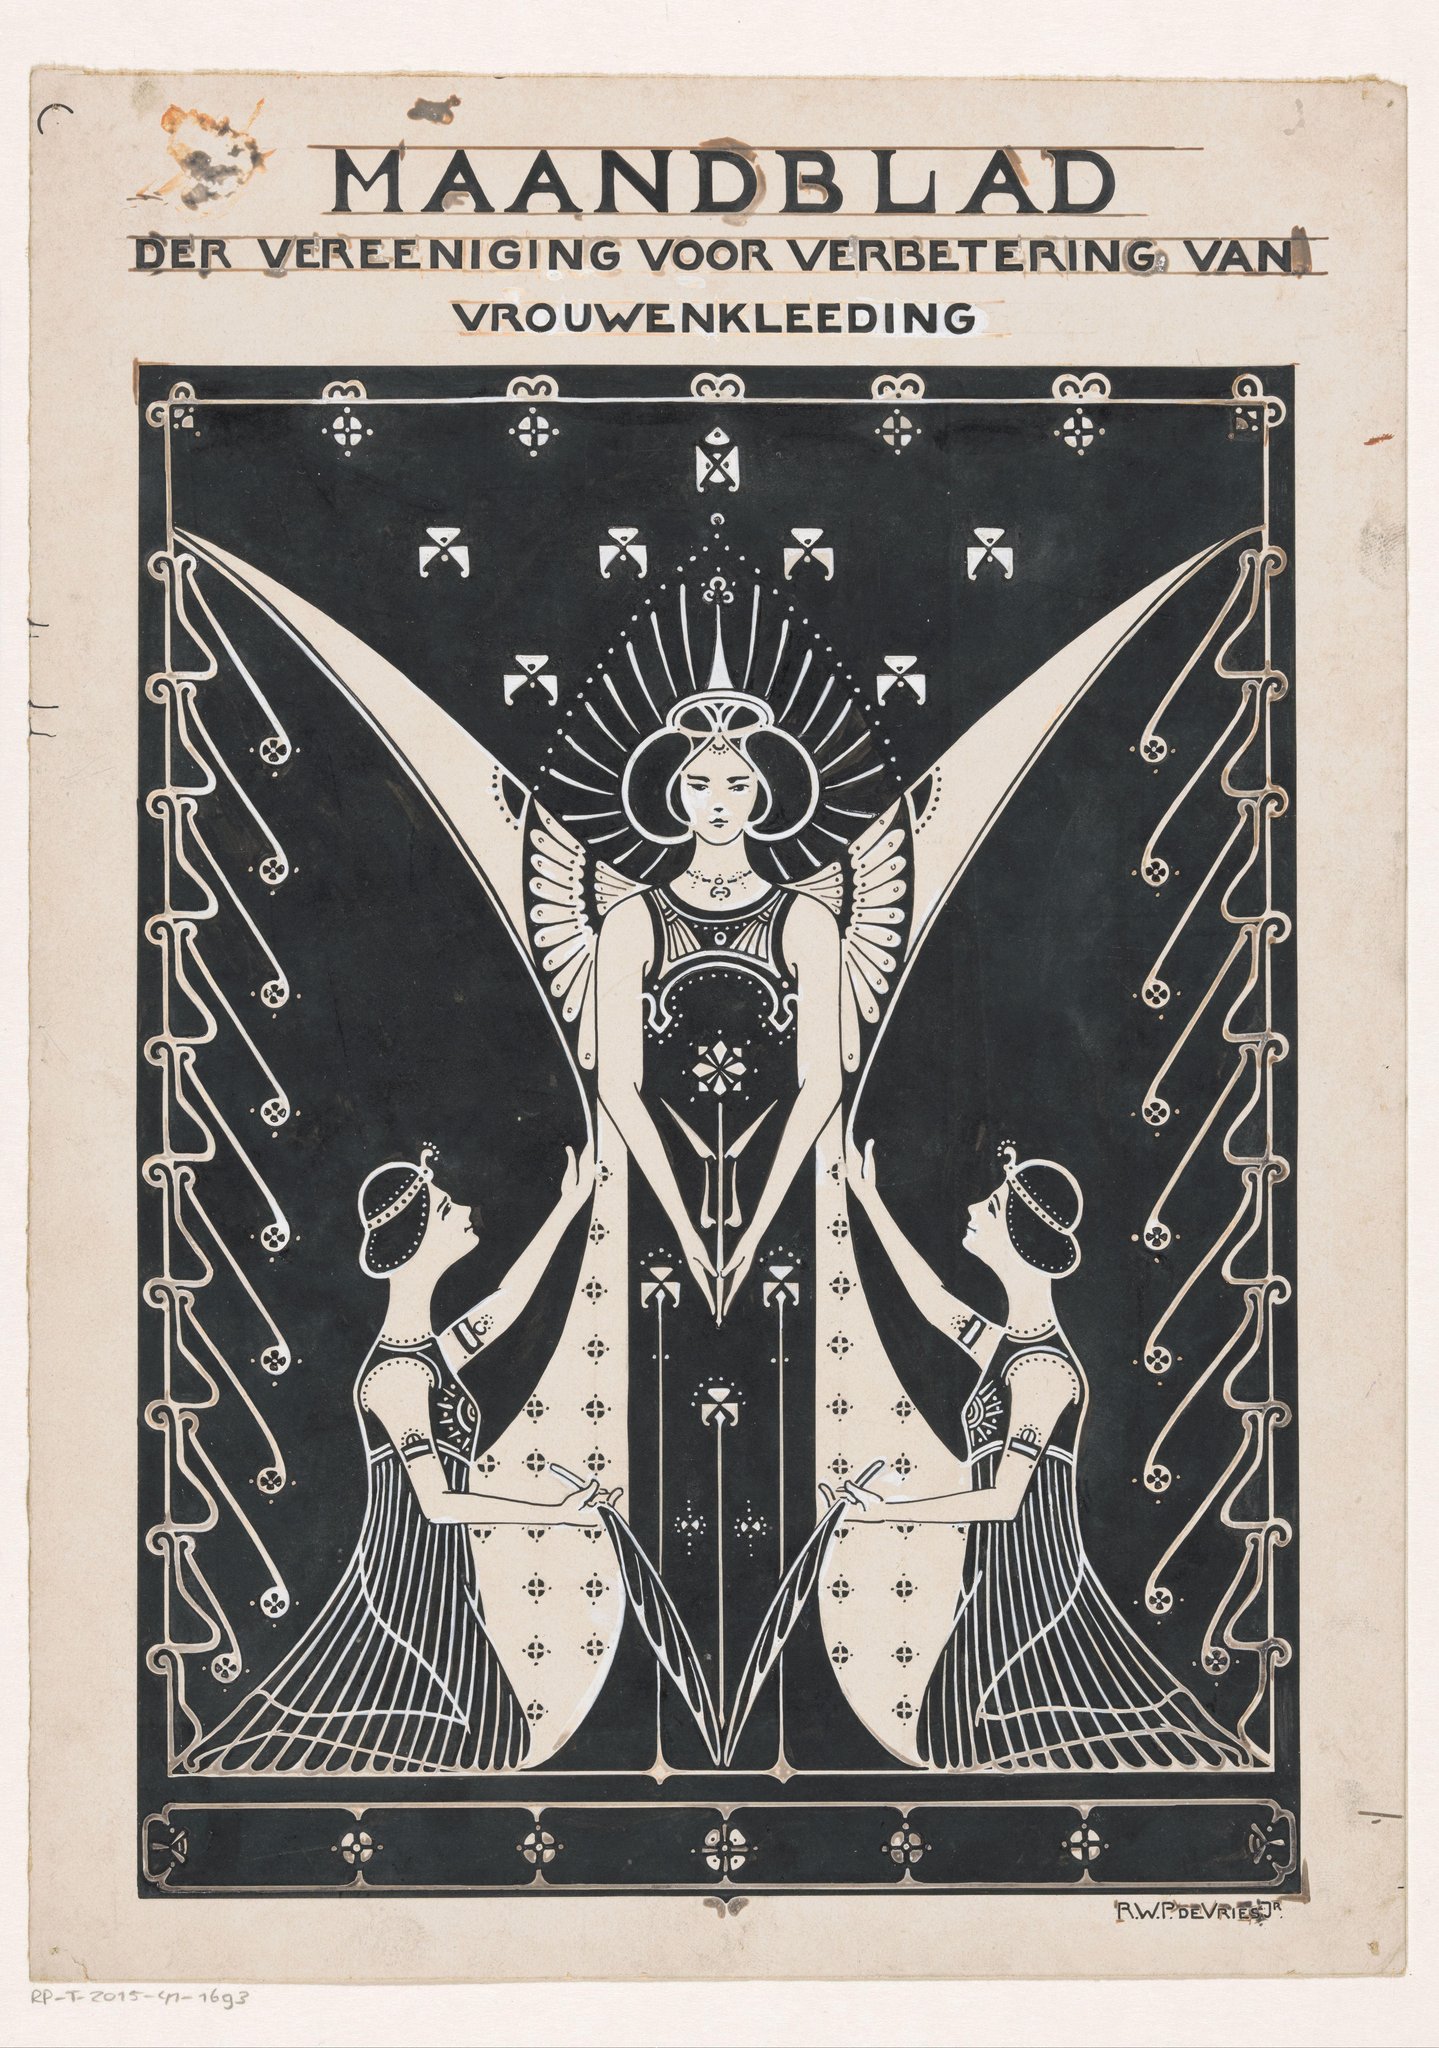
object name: drawing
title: Omslagontwerp voor: Maandblad der Vereeniging voor verbetering van vrouwenkleeding, c. 1901-1909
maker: reinier willem petrus de vries (1874-1953)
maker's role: draughtsman, print maker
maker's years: 1874-1953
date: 1901-1909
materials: cardboard, paint, ink, pencil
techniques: brush, pen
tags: ornaments ~ art, standing figure - aa - female human figure, dress, gown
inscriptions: signature: ‘R.W.P. DE VRIES JR’, :, collector's mark: Lugt 2228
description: Staande gevleugelde vrouw in een mouwloze versierde jurk met de handen voor haar lichaam gevouwen. Naast de vrouw knielen twee vrouwen. Ze reiken elk met een hand op naar de vrouw en dragen in de andere hand palmtakken. De voorstelling is omlijst door een ornamenteel lijnmotief.